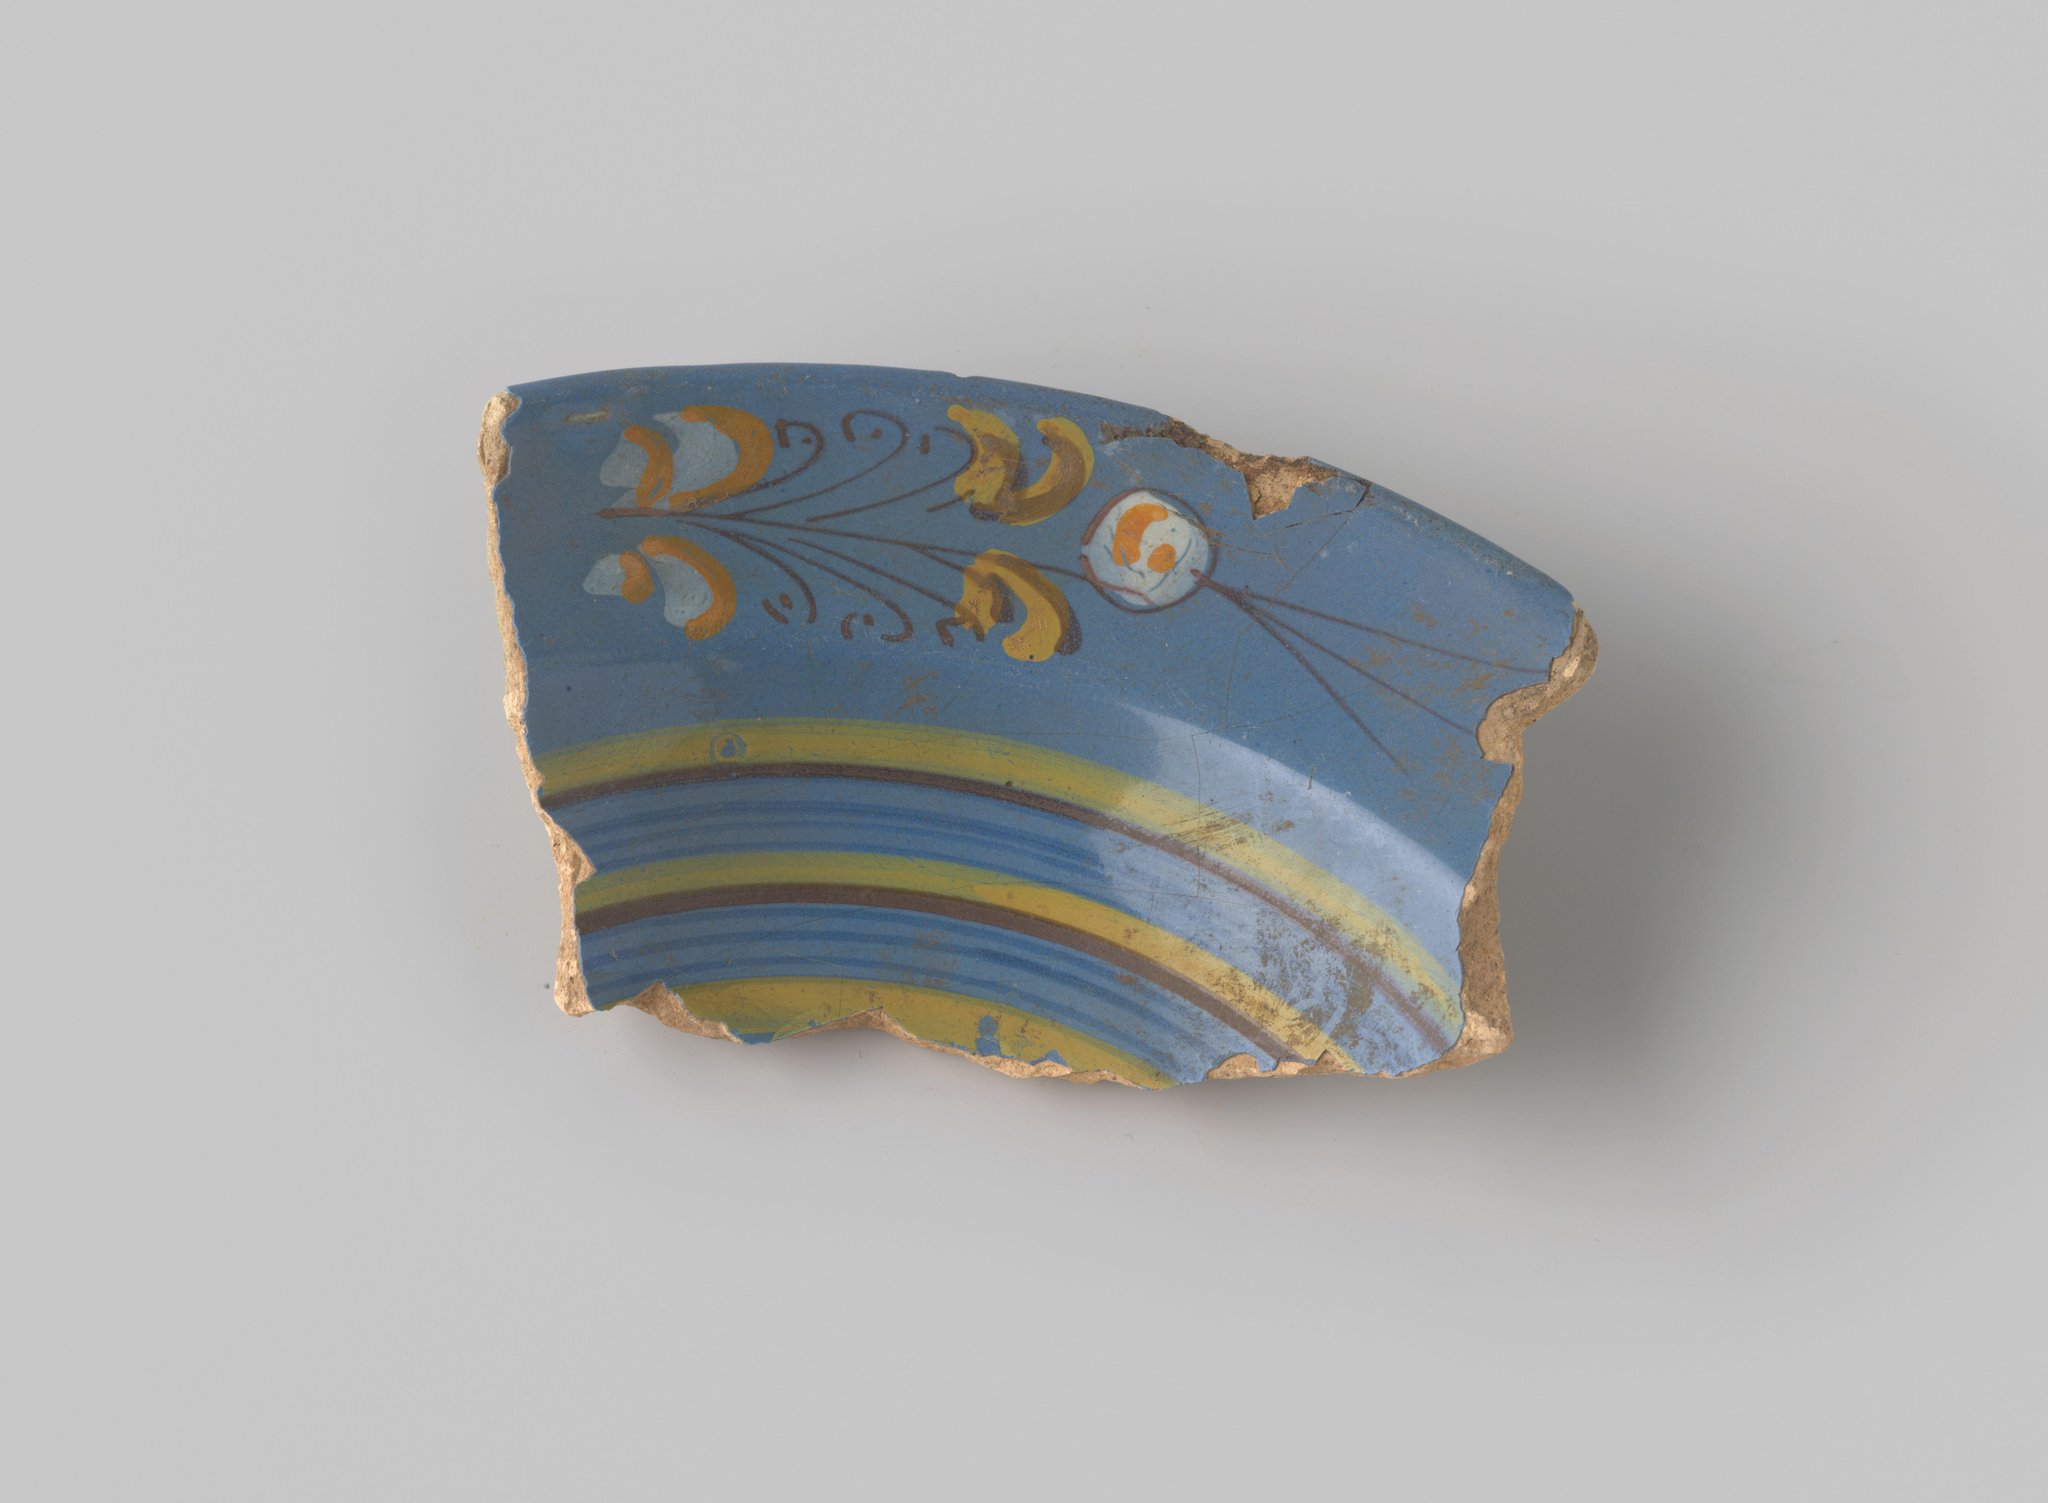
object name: fragment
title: Scherf van roodbakkend aardewerk, aan de voorzijde voorzien van blauw glazuur, met daarop een schildering van een bloem in gestileerde vorm, in bruin, wit, oranje en geel, en strepen in blauw, bruin en geel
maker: Anonymous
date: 1600-1650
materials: earthenware, glaze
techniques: maiolica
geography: northern netherlands